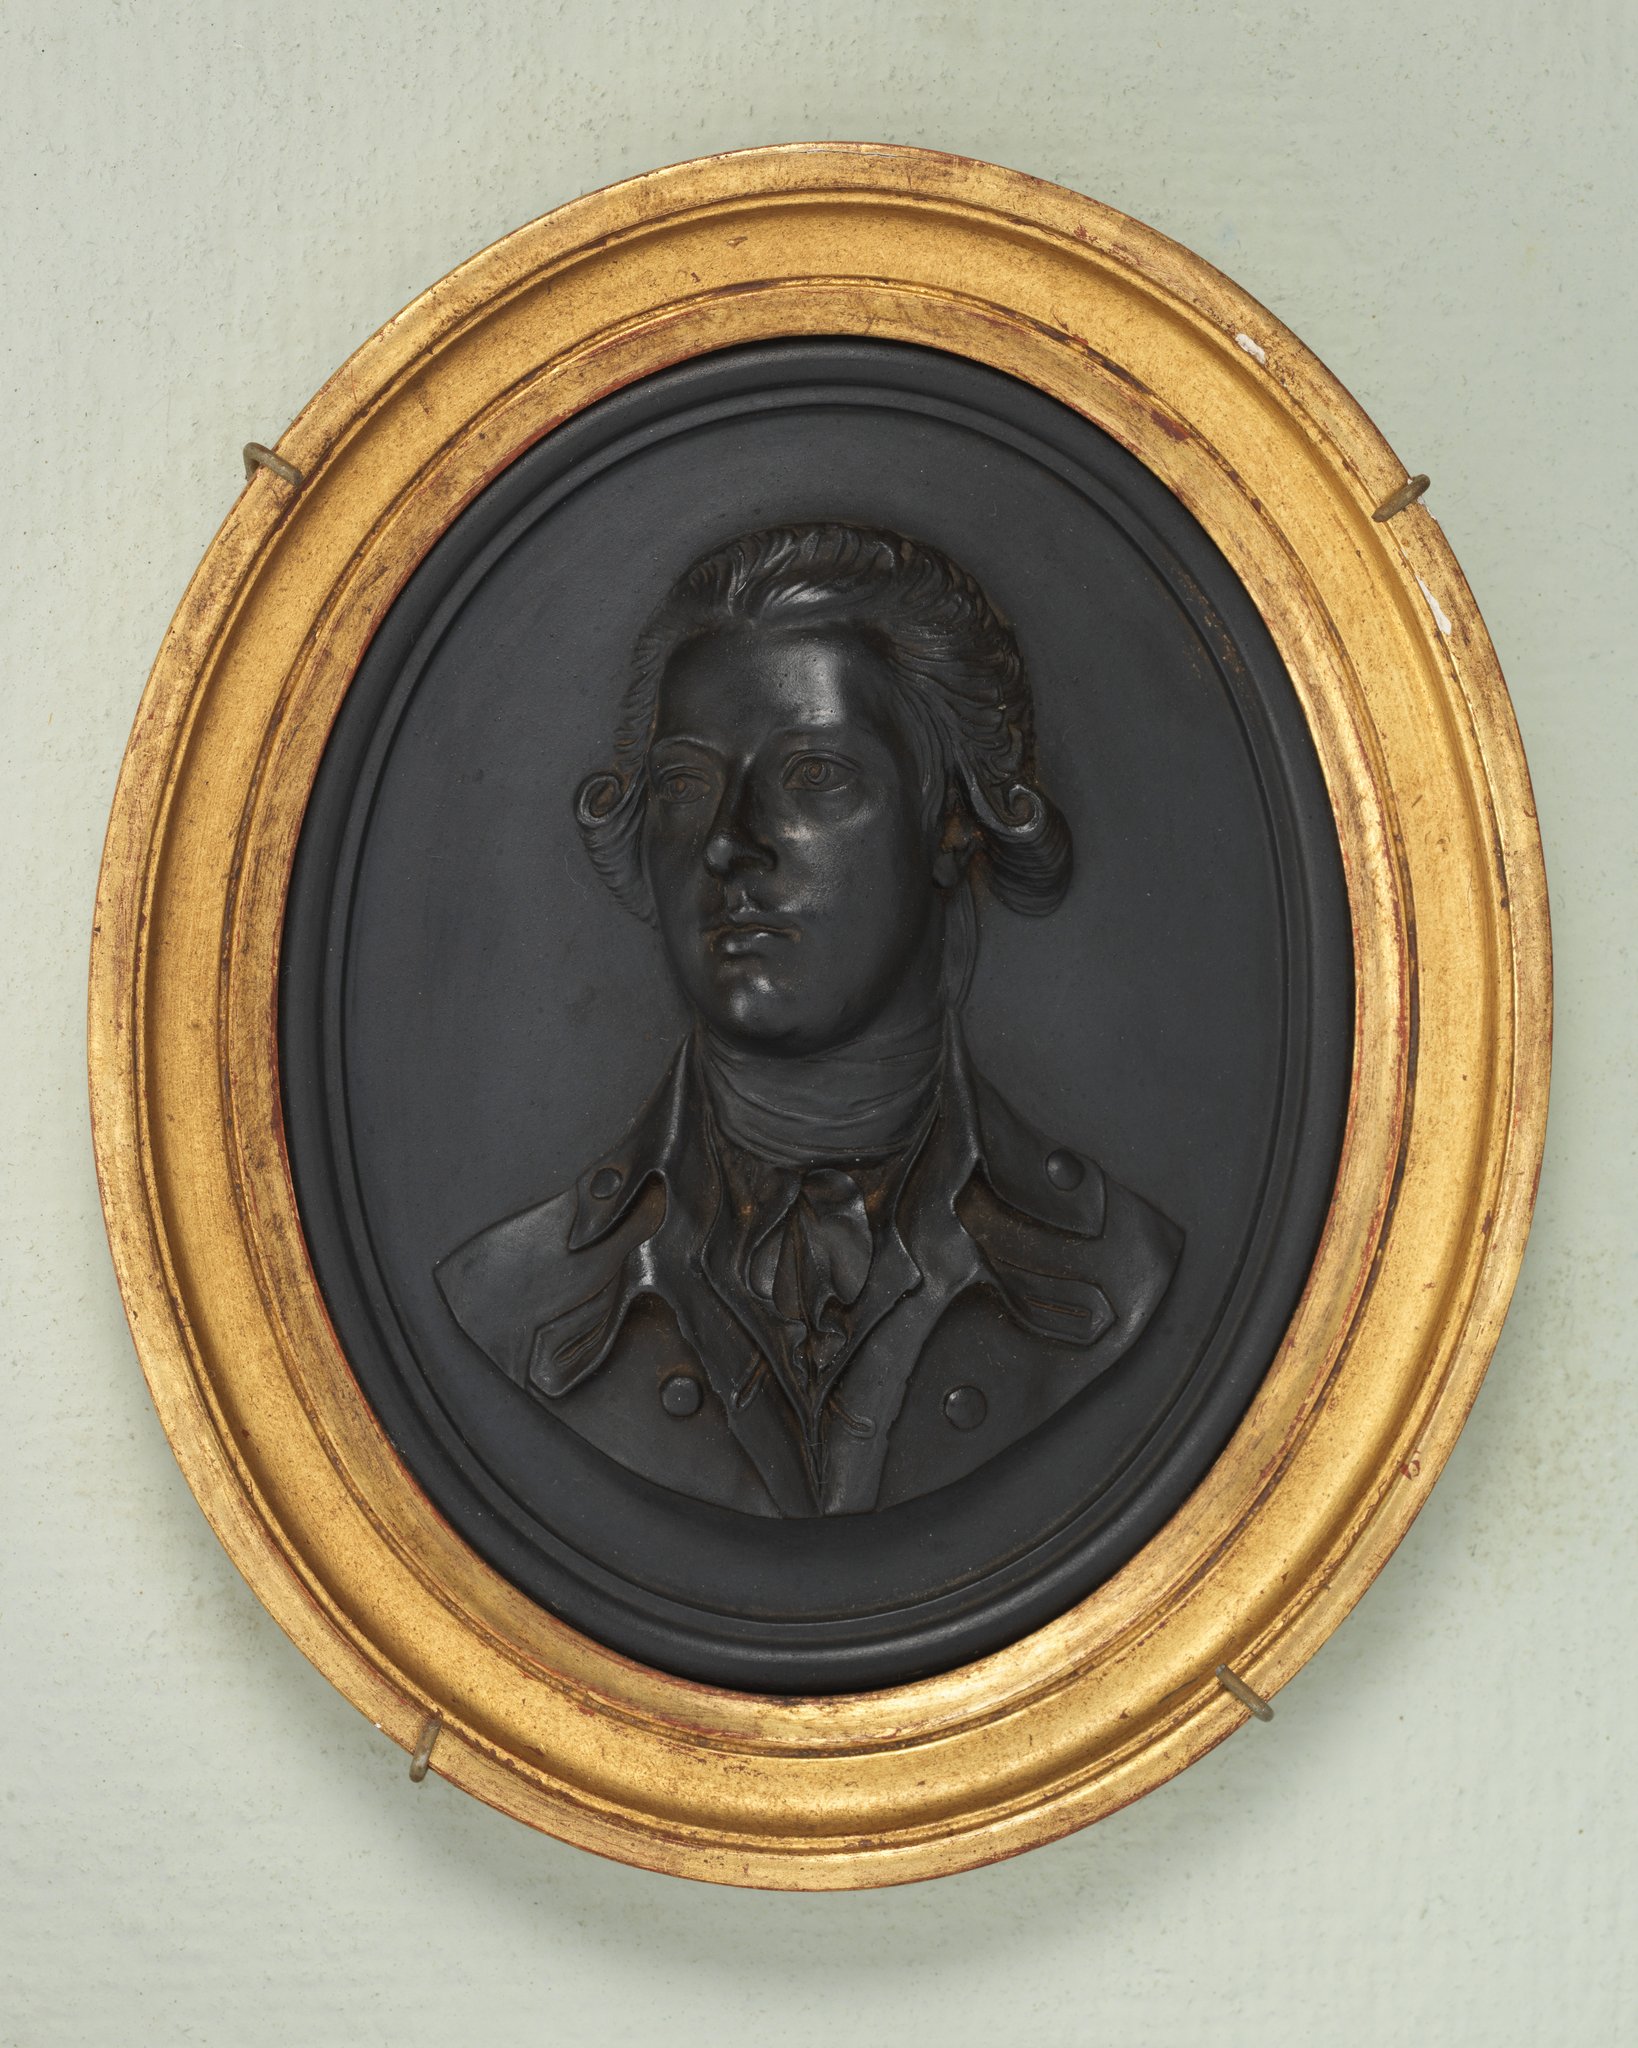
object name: medallion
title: William Pitt, the Younger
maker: wedgwood and co.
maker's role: factory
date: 1787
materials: stone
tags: men,portraits